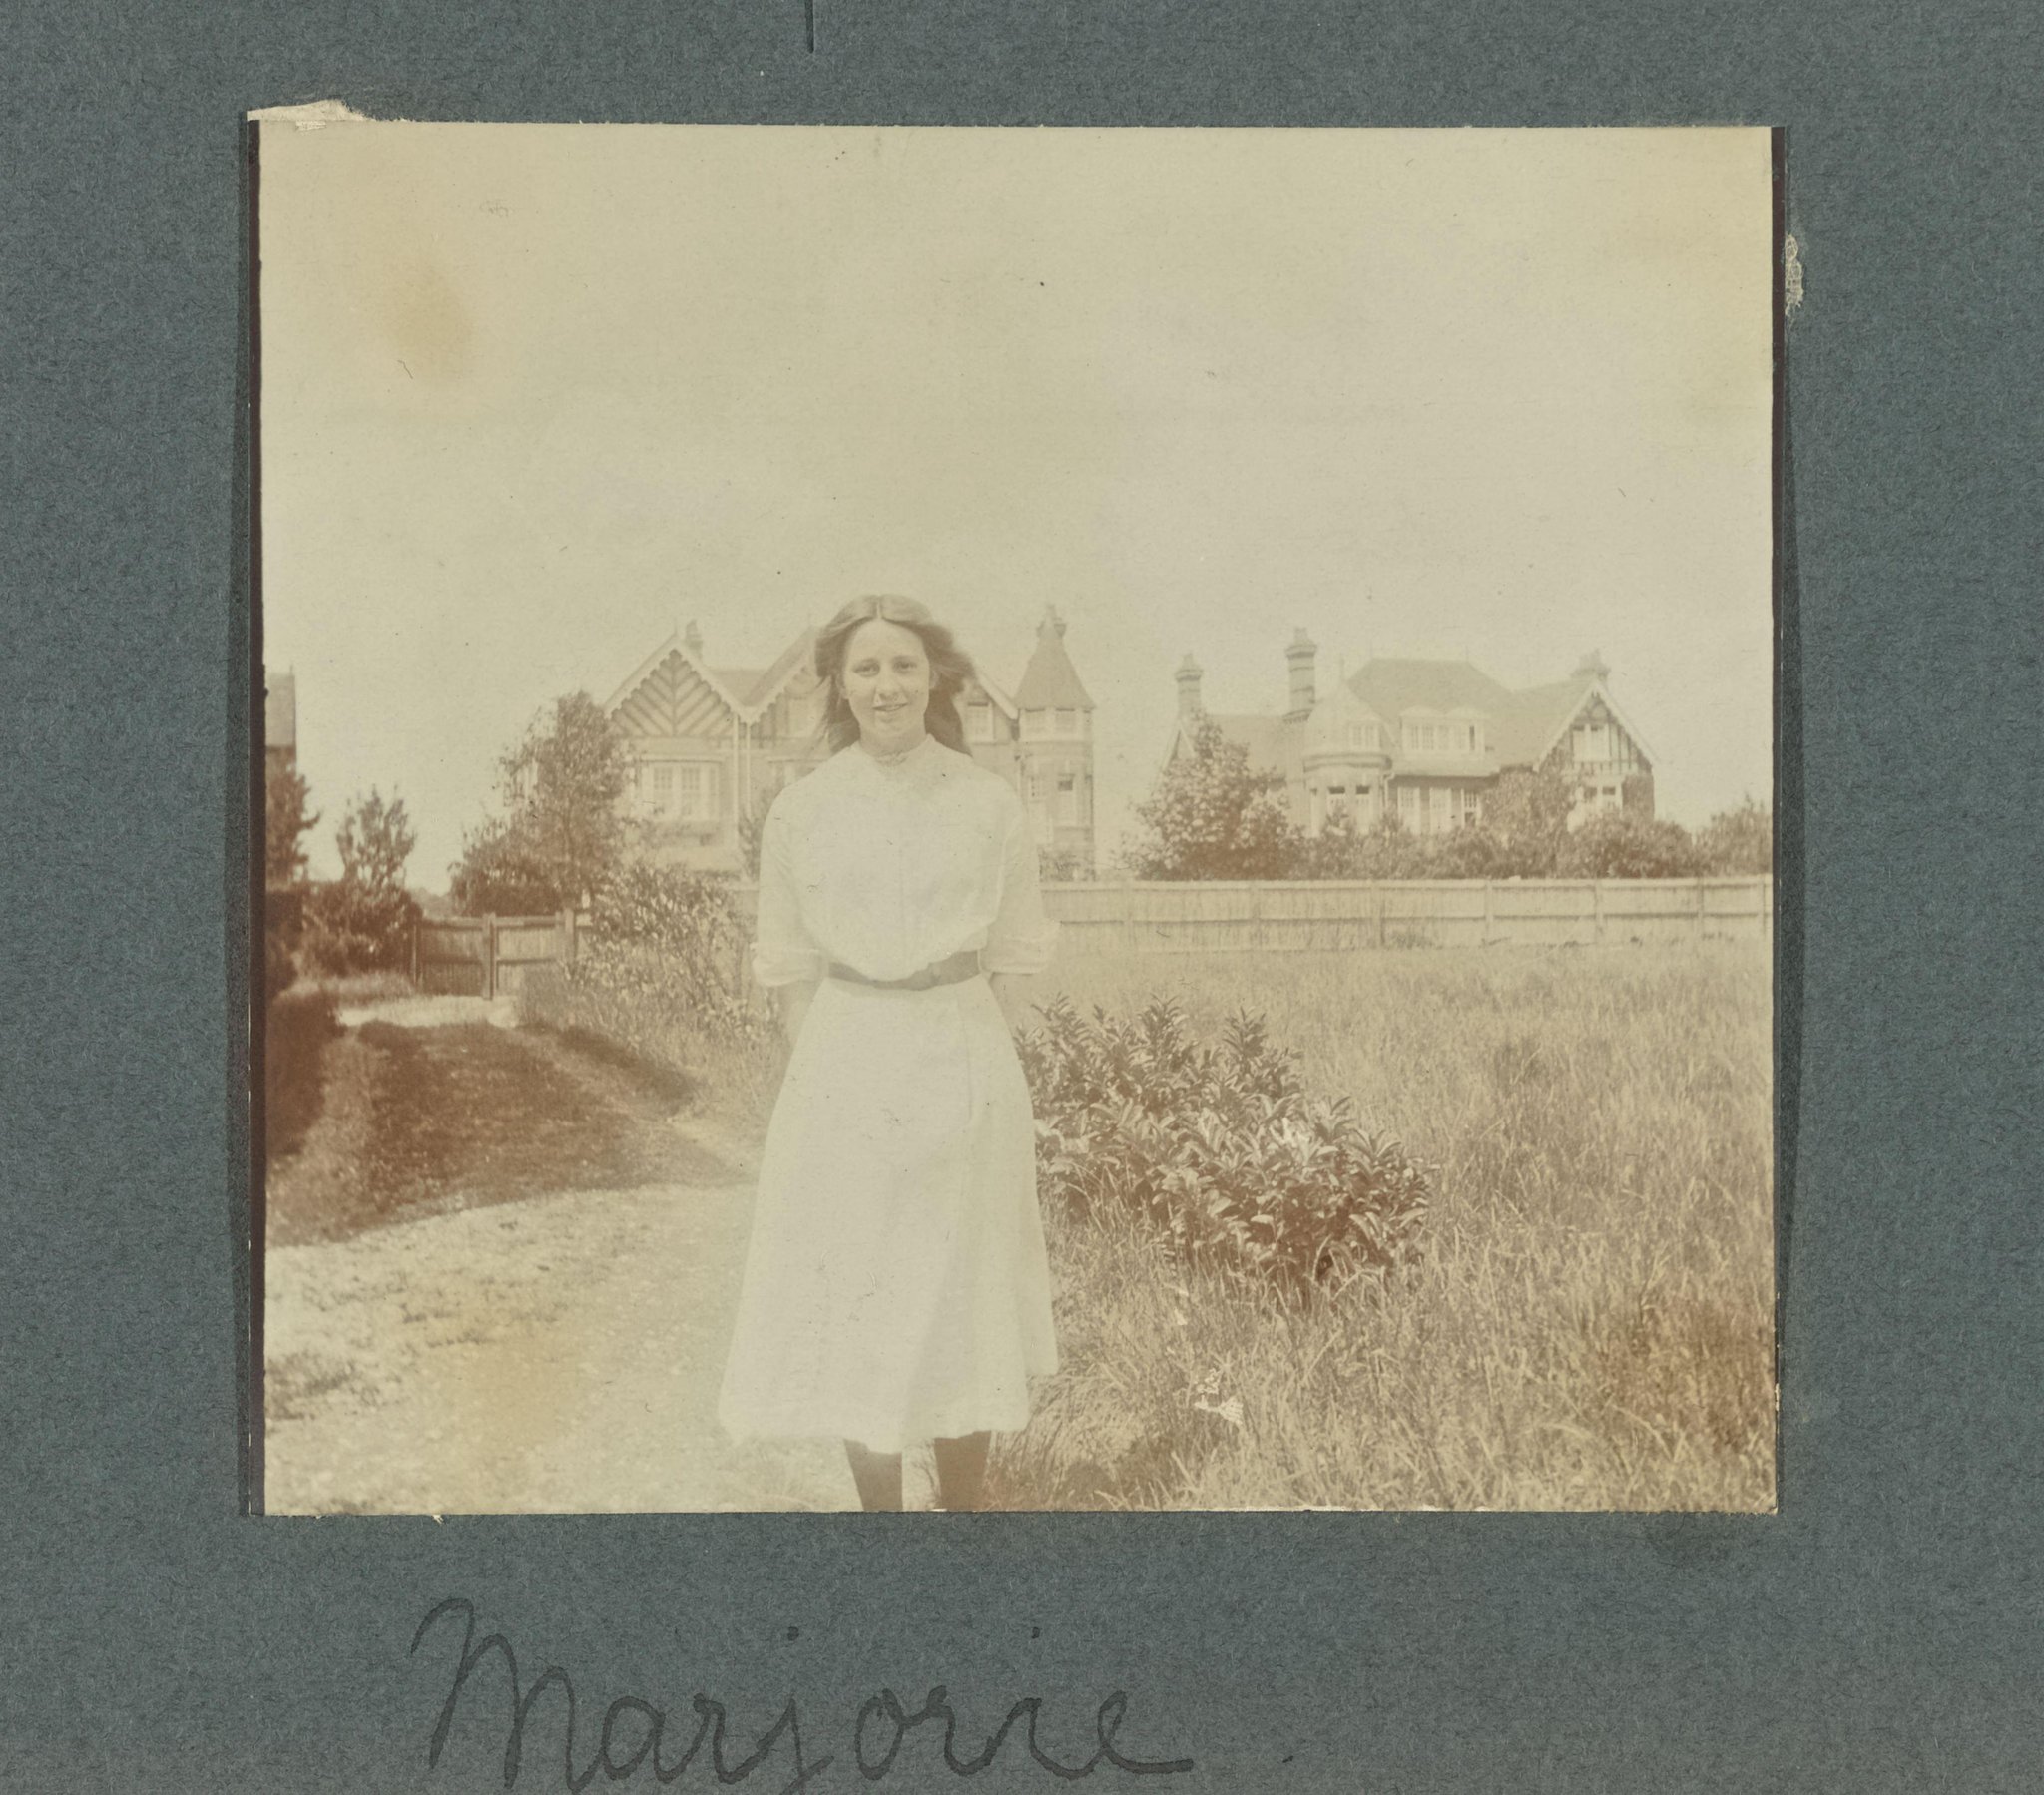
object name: photograph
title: Marjorie in landelijke omgeving met gebouw op de achtergrond in Bexhill-on-Sea in Engeland, 1913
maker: Anonymous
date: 1913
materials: photographic support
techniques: gelatin silver print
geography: bexhill-on-sea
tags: england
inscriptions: inscription: ‘Marjorie’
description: Marjorie in landelijke omgeving met gebouw op de achtergrond in Bexhill-on-Sea in Engeland.